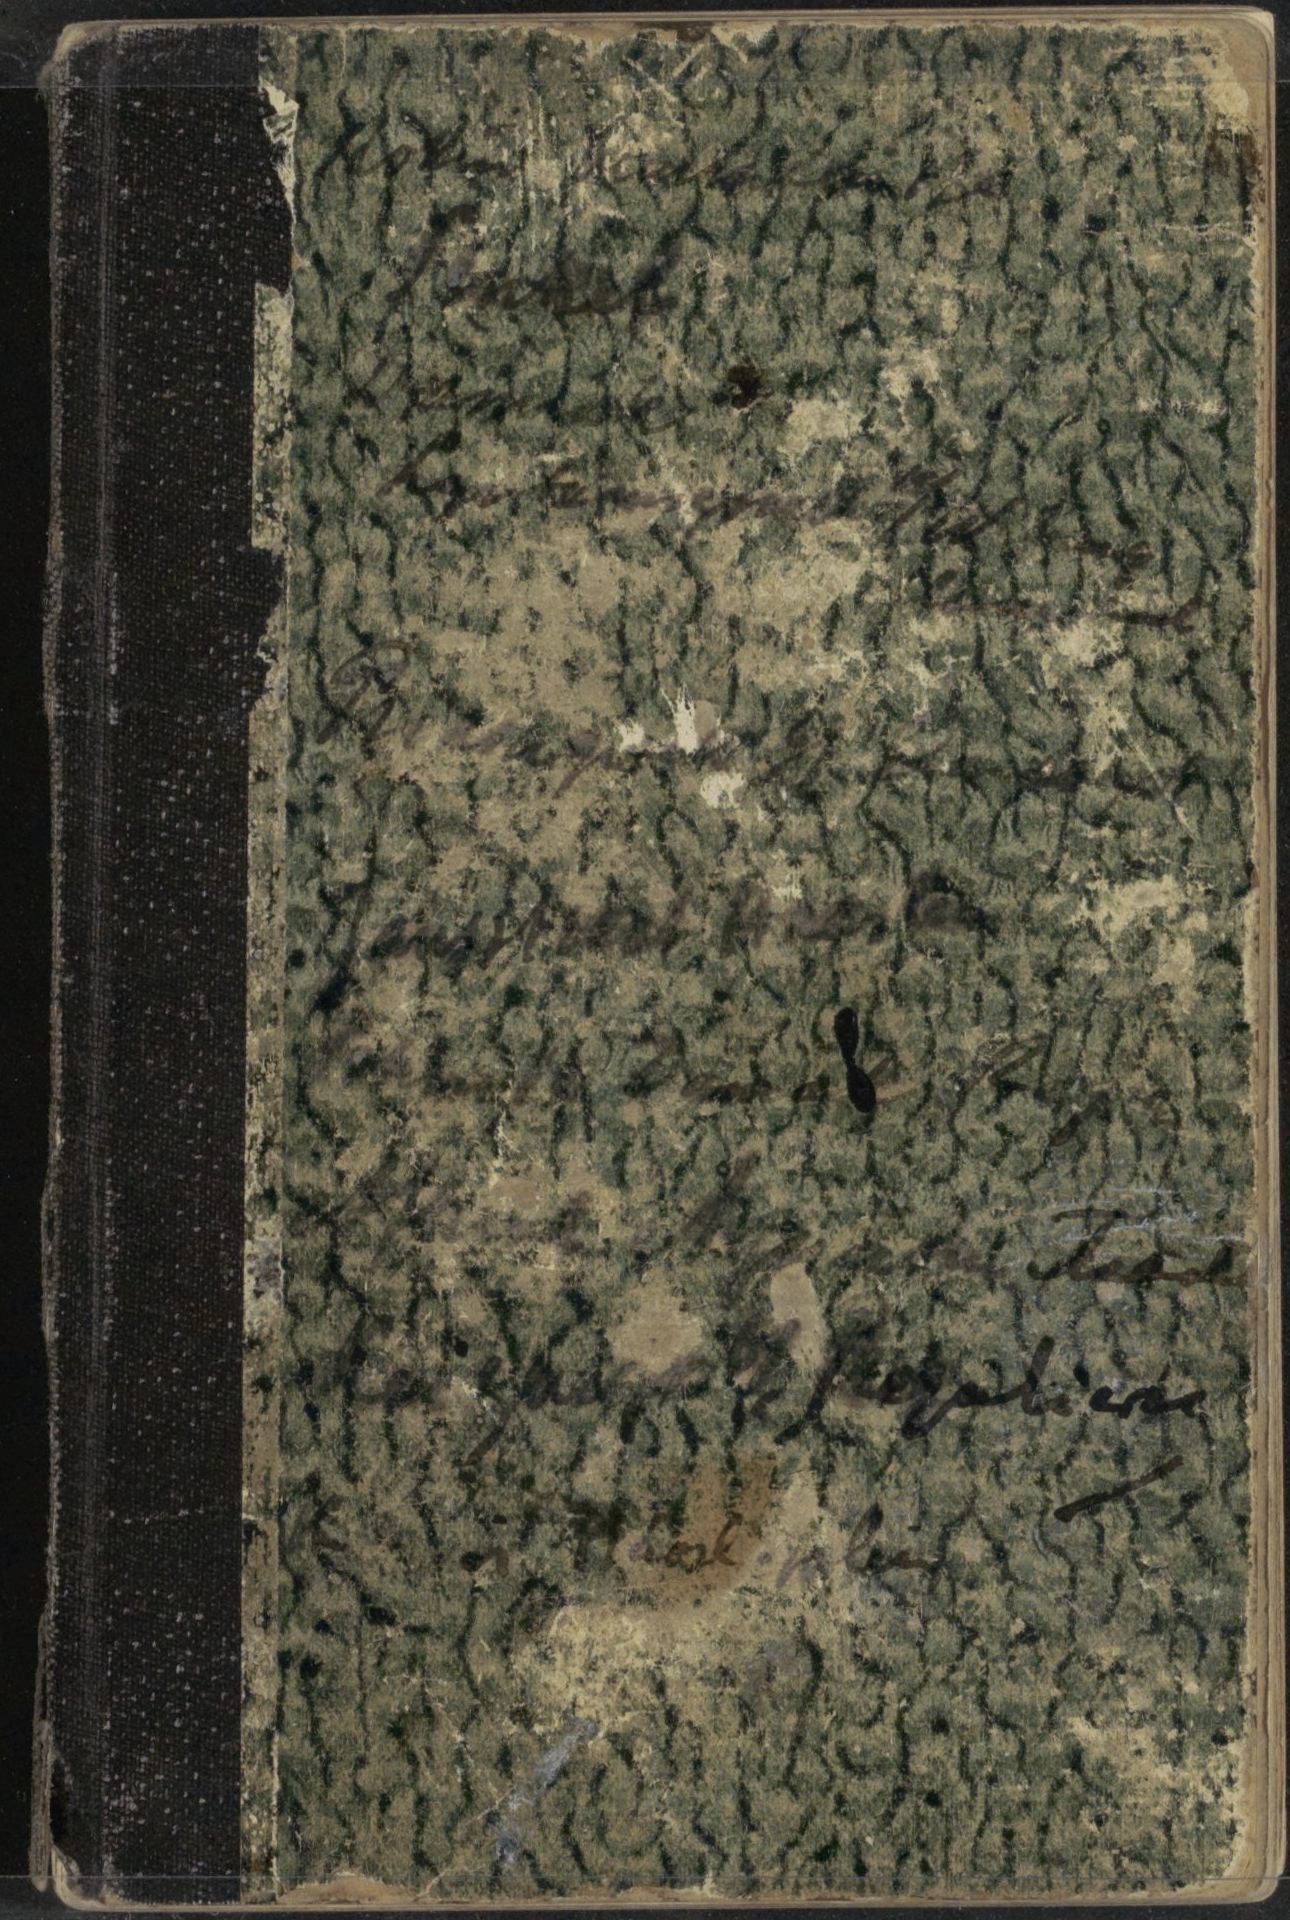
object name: sketchbook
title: Schetsboek met 46 bladen vervaardigd te Amsterdam en Haarlem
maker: george hendrik breitner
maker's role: draughtsman, painter, print maker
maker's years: 1857-1923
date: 1903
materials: cardboard, chalk, linen, paper, pencil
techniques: marbling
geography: haarlem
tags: urban housing, church (exterior), street, haarlem, amsterdam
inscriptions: annotation: ‘Paard. Rokin/ Rokin beurspleintje/ afbraak Sinkel Nieuwendijk/ Damrak studies/ Lijnbaansgr. b/ Leidsche Kruisstraat/ Prinsengr. [...] d Elandsgracht/ Damrak/ Kerk te Haarlem/ Damrak/ afbraak Agnietenstraat/ Prins Hendrikkade avond/ Oudekerks toren/ Brug Keizersgr. b/d Reguliersstraat/ Toren kerk Haarlem/ Korte Prinsengracht b/ Brouwersgr/ Kermis Haarlemmerplein/ Spaarne Haarlem/ Muntplein uit de Bodega/ Huizen hoek Kalverstraat & Munt/ Brug Singel b/d Paleisstraat/ Afbraak Damrak (Passage)/ Poortje Heiligland Haarlem/ Damrak v.d. oude brug gezien/ Spui/ Rokin met OZ. Kapelpoort/ afbraak Agnietenstraat/ Meiden Haarl. plein/ Keizersgr. b/d Beerenstraat/ Handkarren Stadh. k. Vondelpark/ Damrak/ Beulingstraat/ Prins Hendrik kade avond’, retailer's mark: ‘Gebrs. Simons/ Amsterdam./ Filiaal/ Heiligenweg 34/ Kantoorboek & Papierhandel./ Linieer- en Perforeer-inrichting./ No. 141 Blanco/ Bij nabestelling van dit boek, gelieve men/ bovenstaand nummer op te geven. / per doz f 1.60 per stuk 15’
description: Schetsboek bestaande uit 46 bladen met voornamelijk gezichten te Amsterdam en Haarlem en figuurstudies.